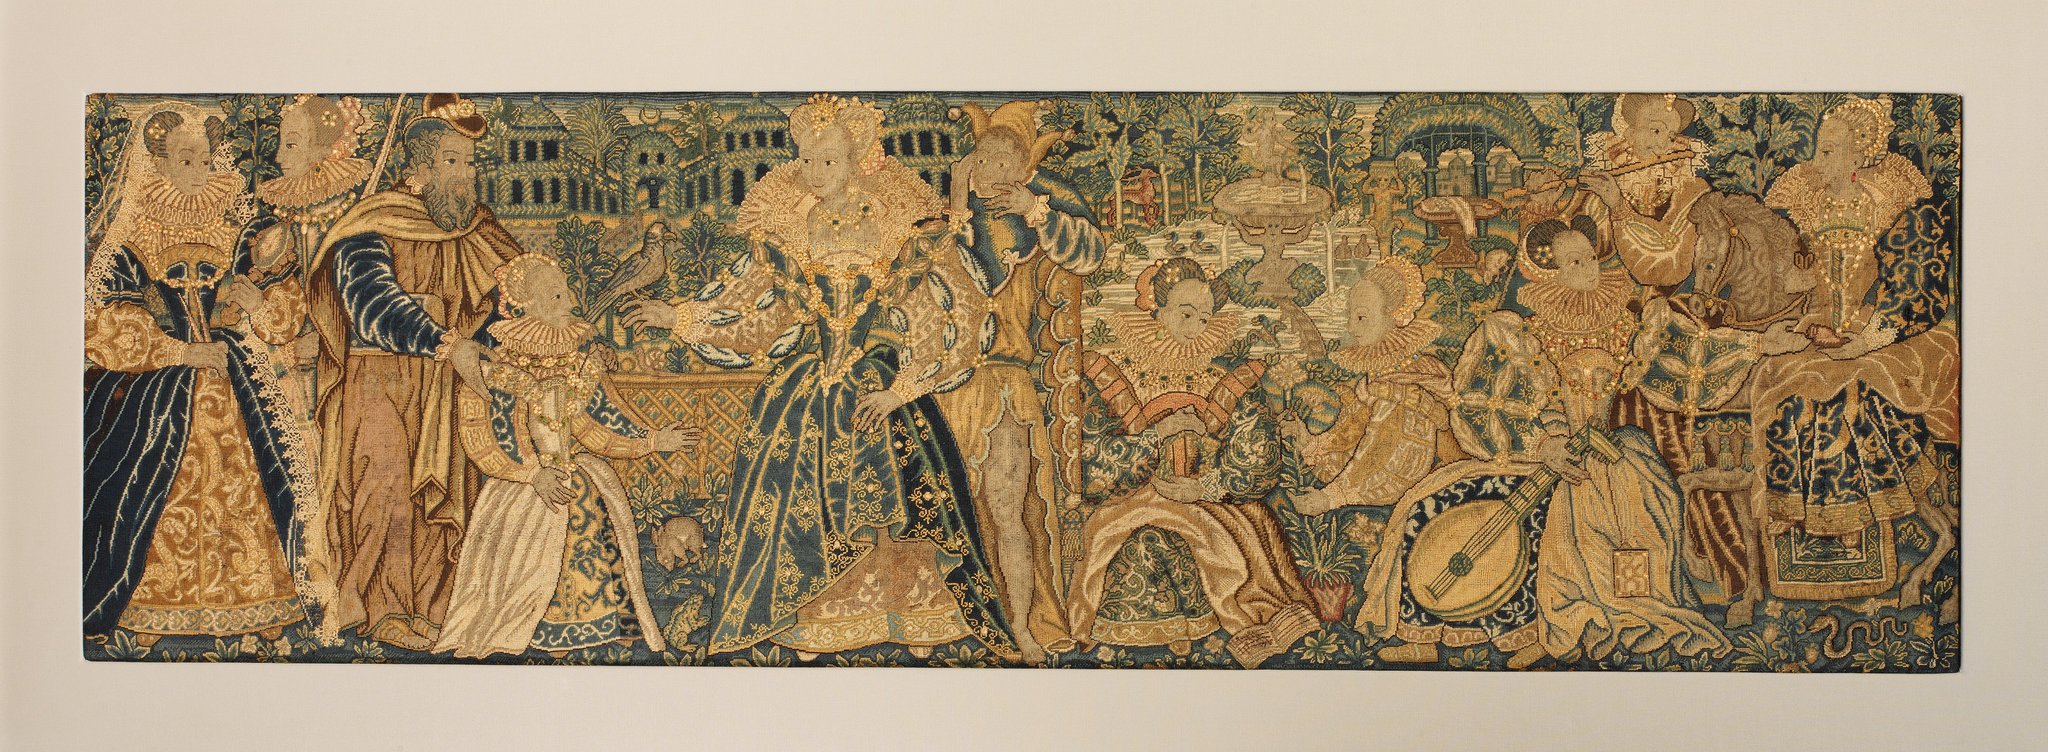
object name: valance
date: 1580-1610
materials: canvas, textile, thread, wool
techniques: stitching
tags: musical instruments,birds,men,women,musicians